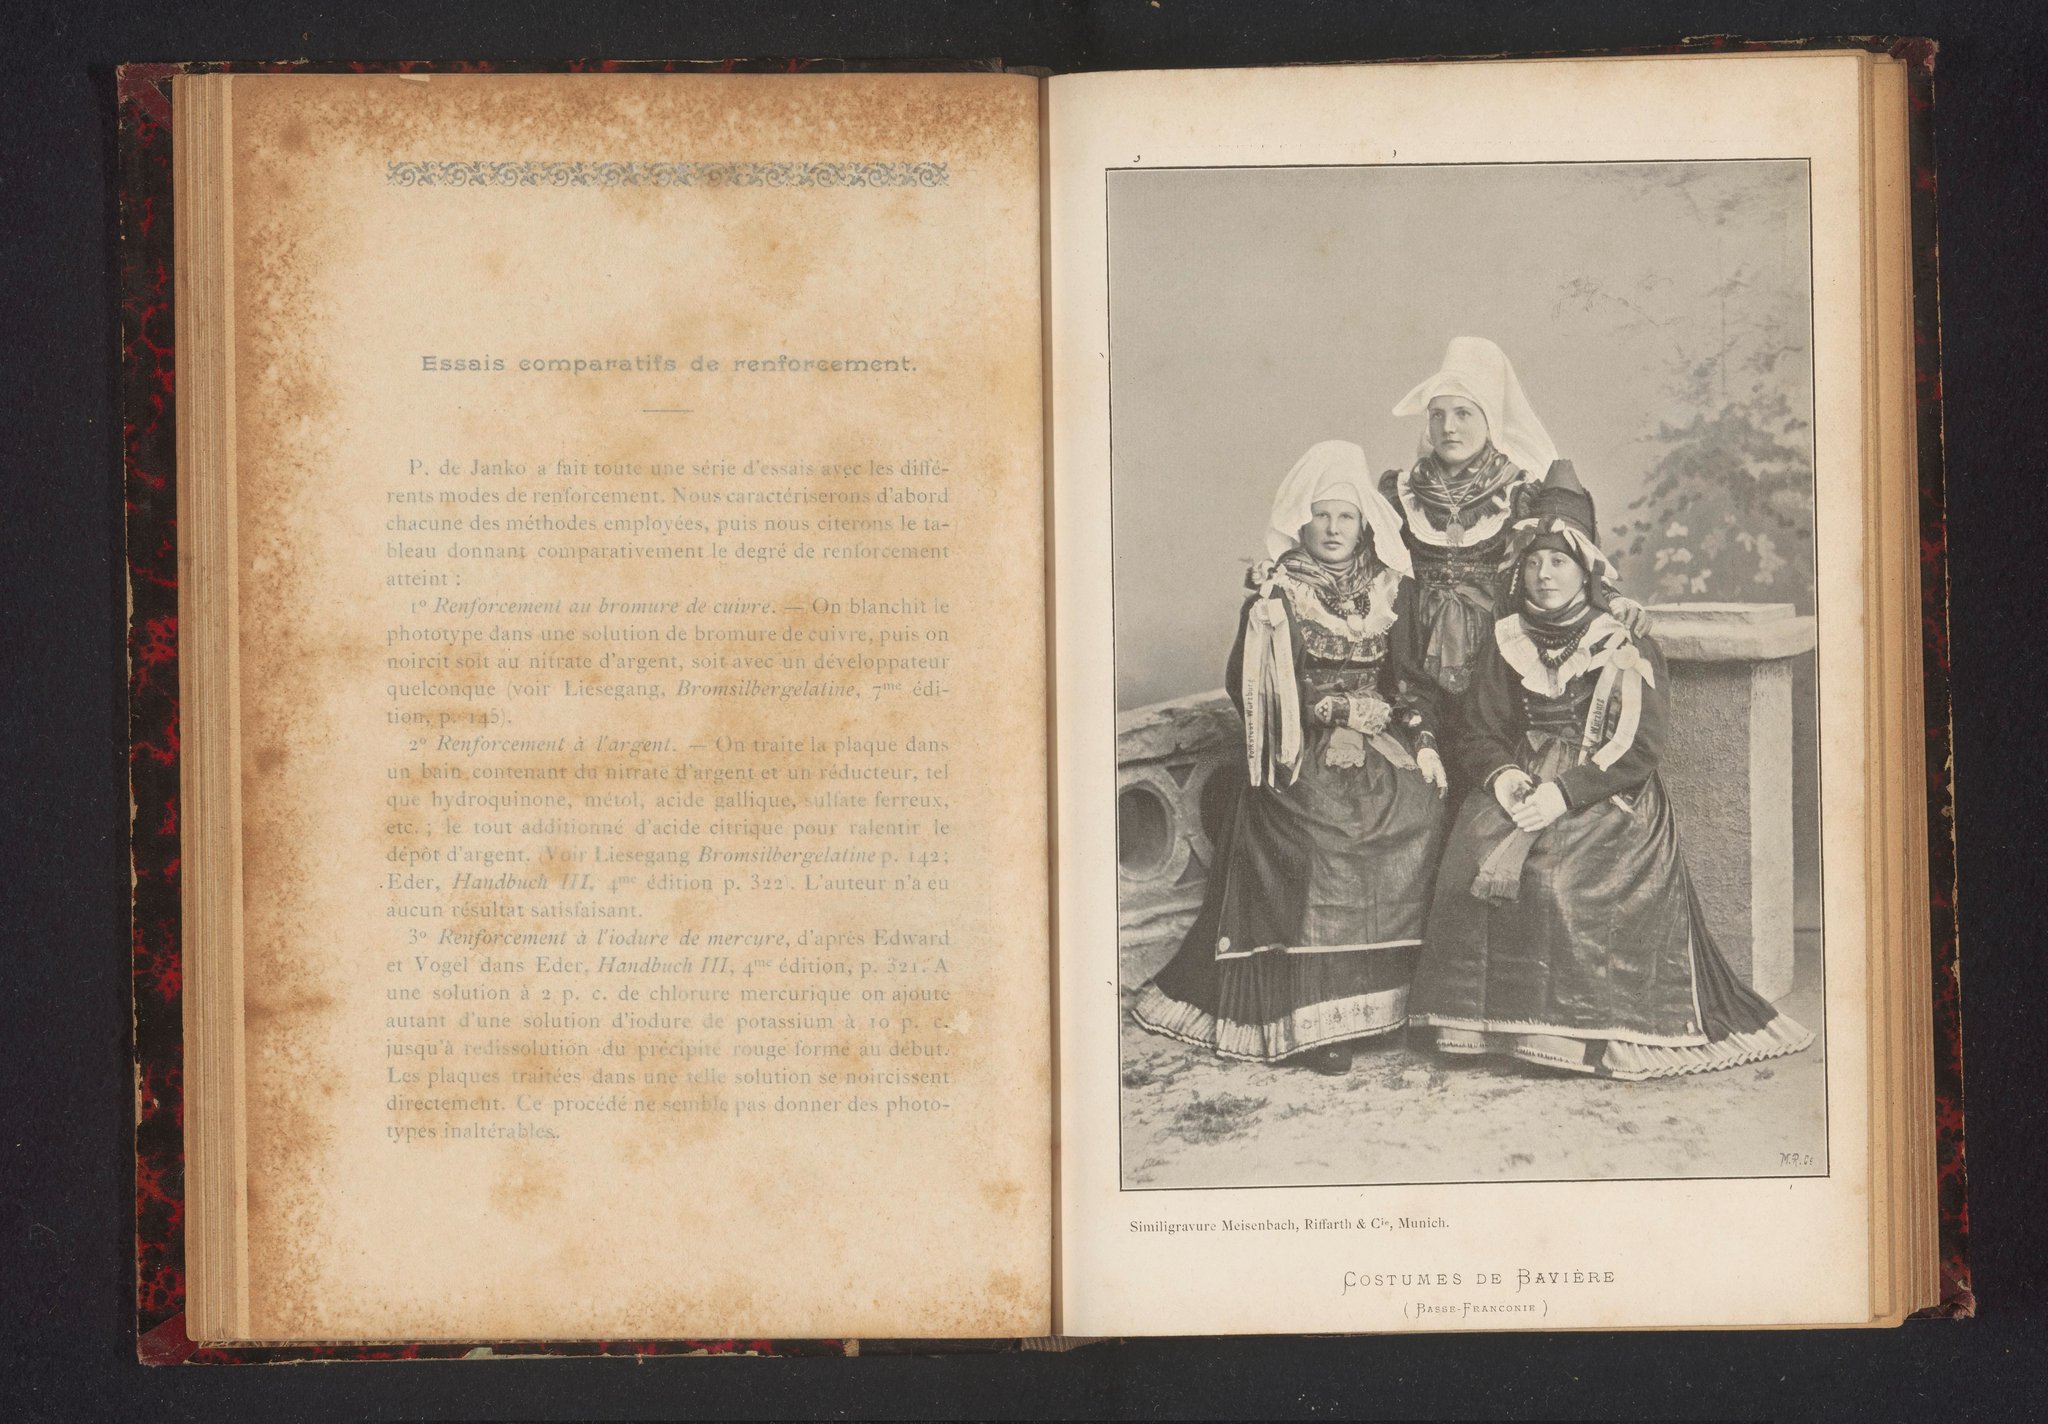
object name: photomechanical print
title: Costumes de Bavière (Basse-Franconie)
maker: Anonymous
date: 1892-1897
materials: paper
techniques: autotype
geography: munich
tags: anonymous historical persons portrayed in a group, in a group-portrait - bb - woman, folk costume, regional costume